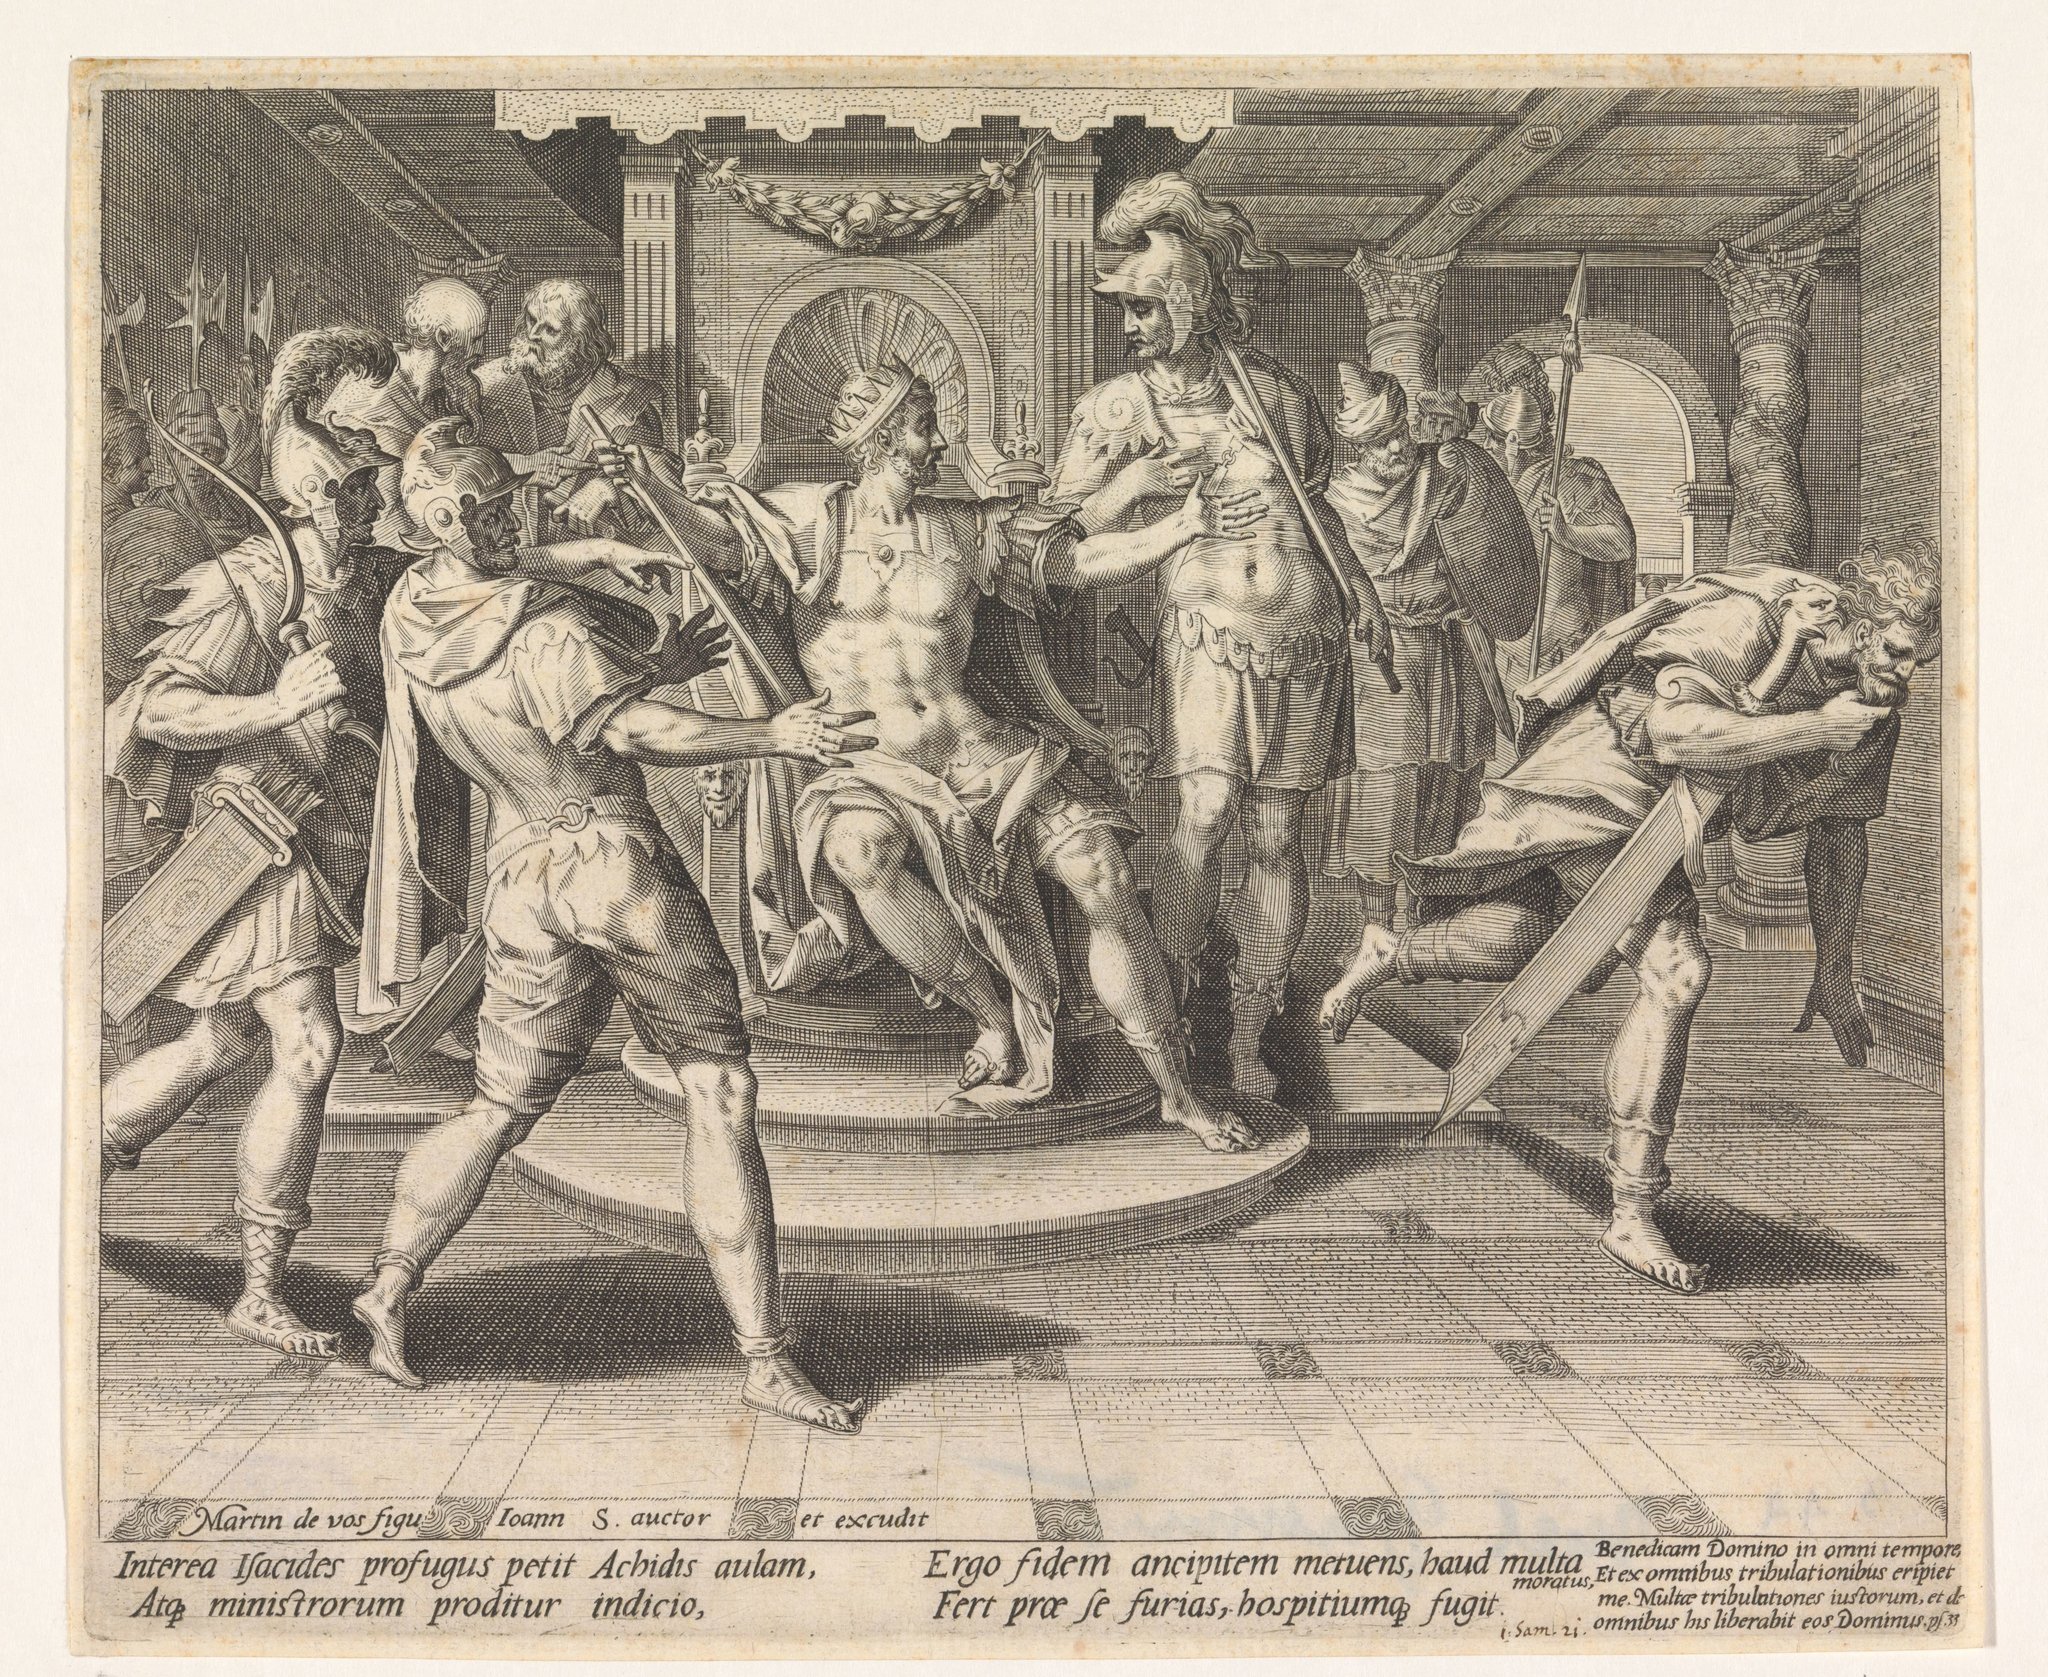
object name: print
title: Geschiedenis van David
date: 1580-1596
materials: paper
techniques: engraving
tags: david sent away by achish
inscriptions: collector's mark: Lugt 11, collector's mark: ‘Hinloopen’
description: Koning Achis op een troon in zijn paleis, omringd door zijn hovelingen en soldaten. David, rechts, simuleert krankzinnigheid door in zijn baard te kwijlen. Met het zwaard van Goliat ontvlucht hij het paleis. De prent heeft een Latijns onderschrift met uitleg en rechts in de hoek een vers uit psalm 33.